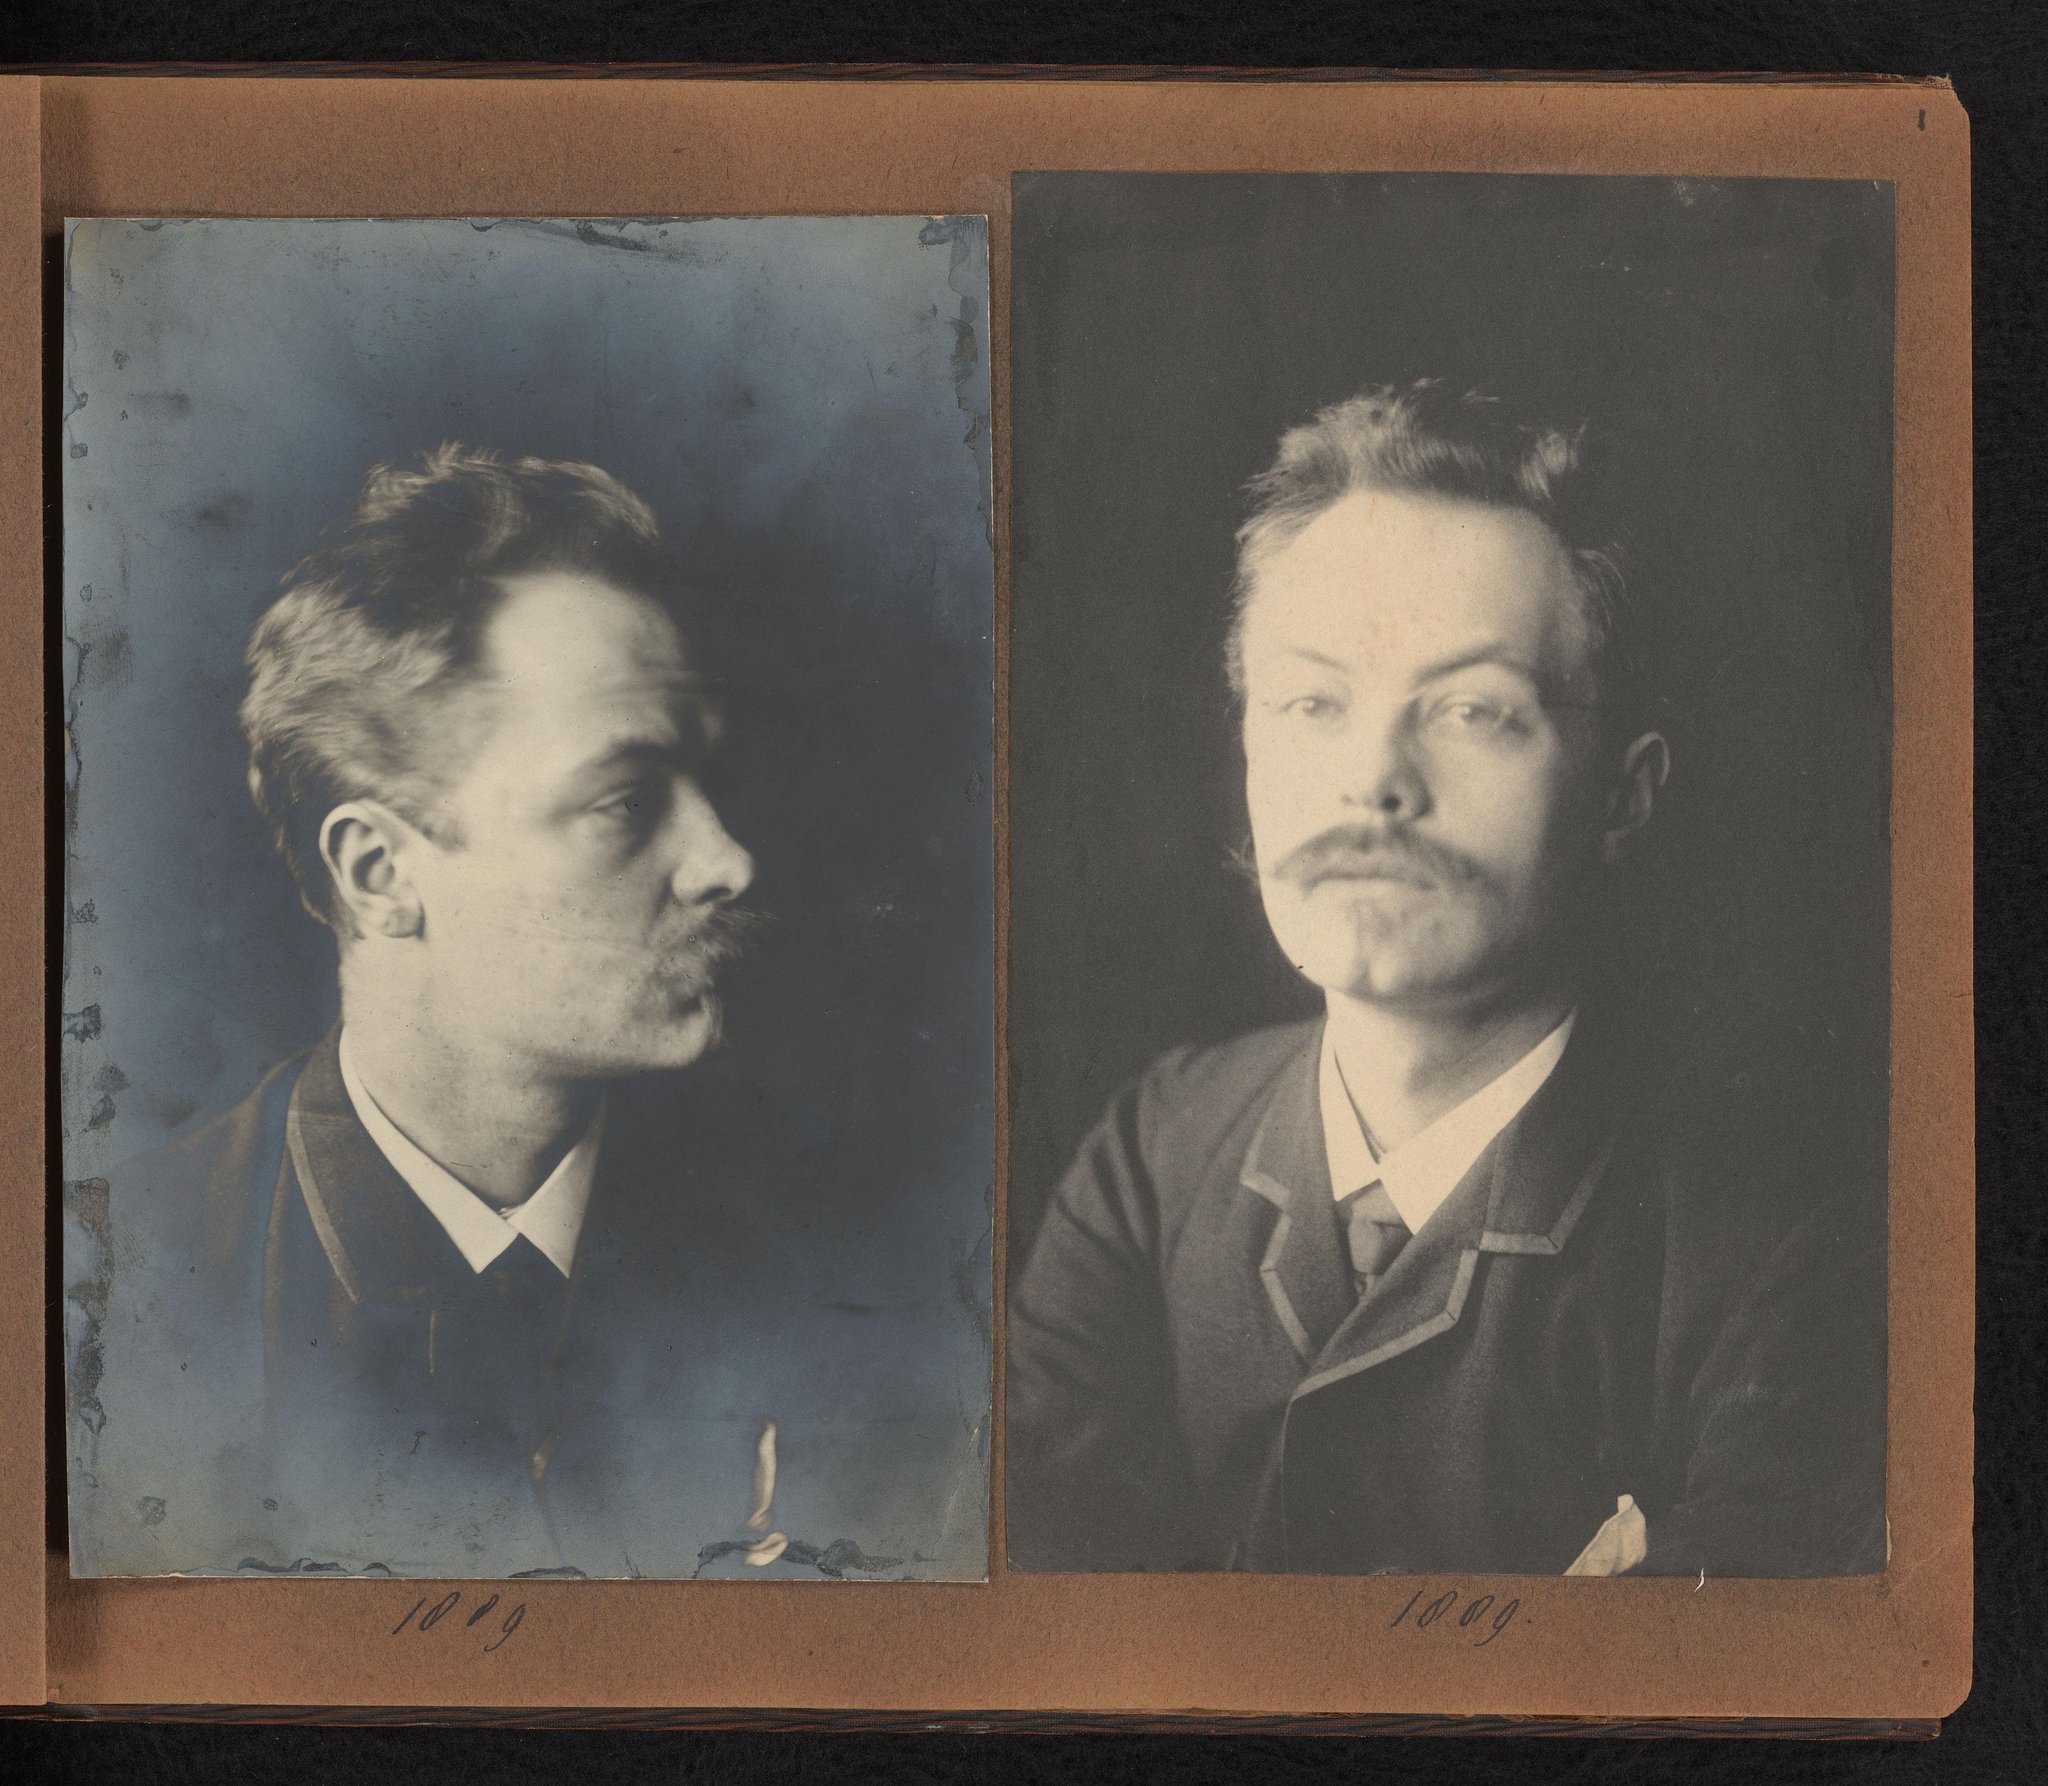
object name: photograph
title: Bladzijde uit het fotoalbum van de familie Diepenbrock met 2 portretfoto's van Alphons Diepenbrock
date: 1889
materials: cardboard, photographic support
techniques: photography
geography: amsterdam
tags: alphons diepenbrock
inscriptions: date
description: Bruin albumblad 1 van familiealbum van Alphons Diepenbrock.